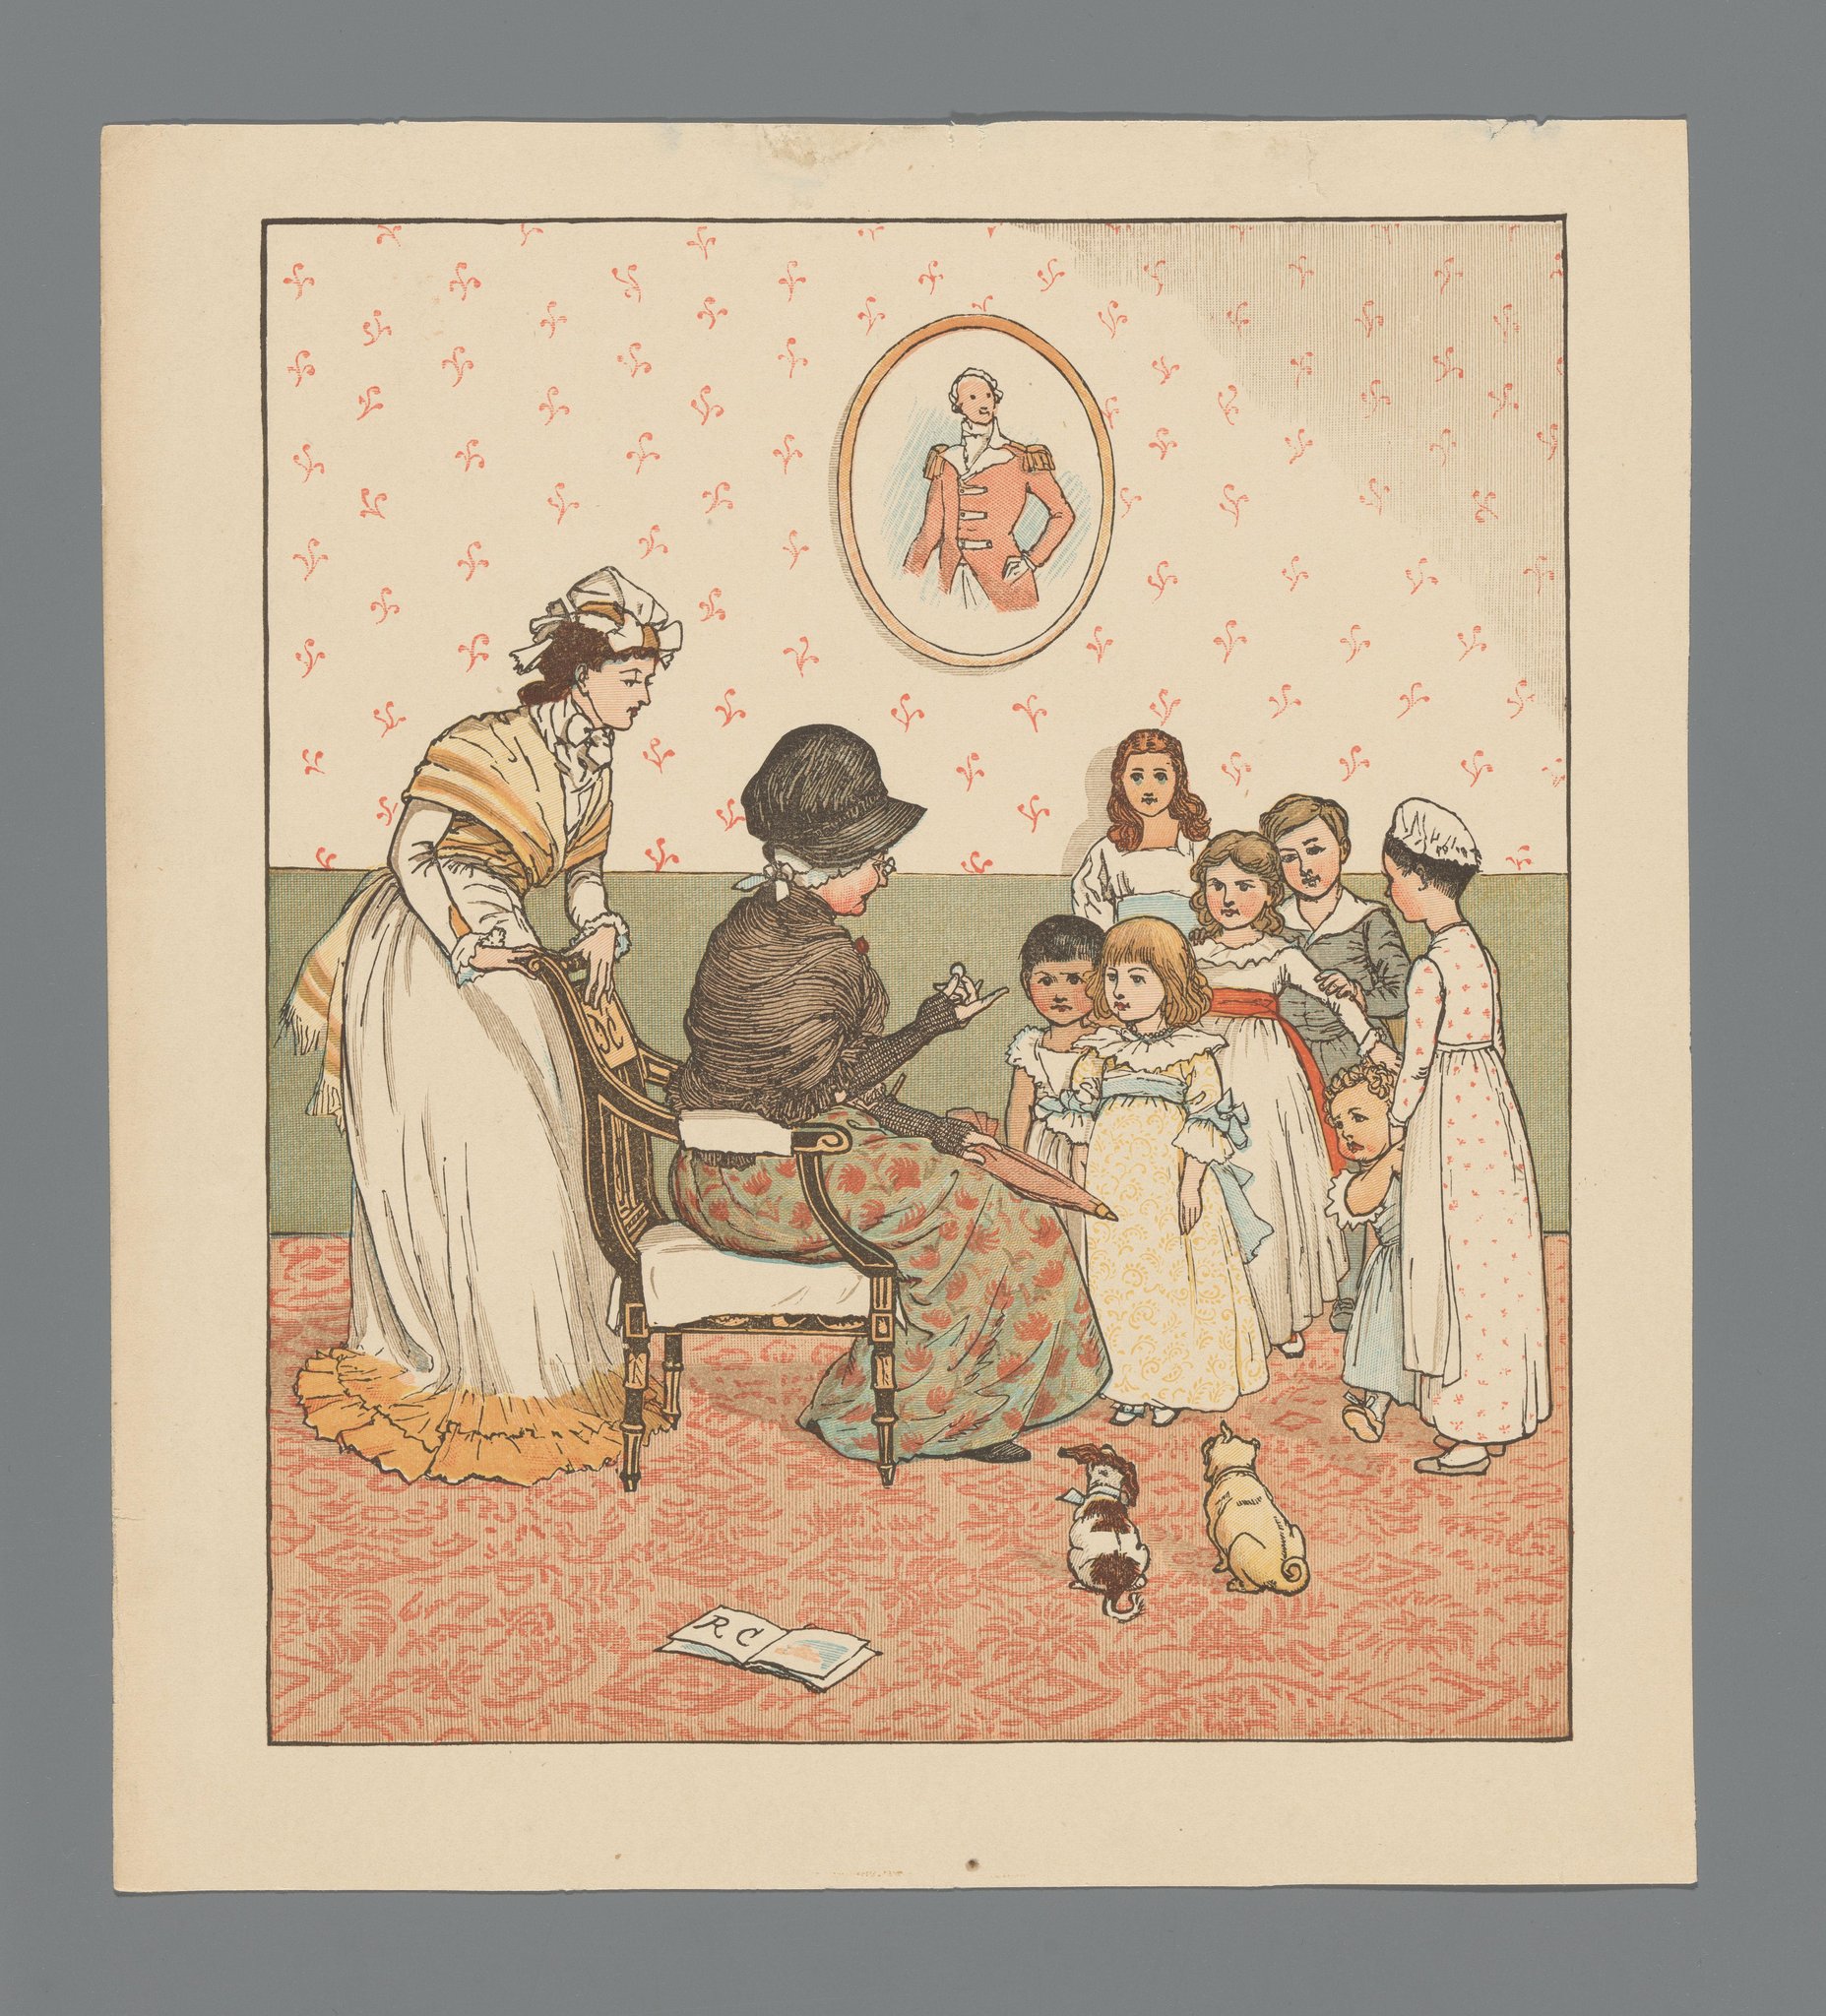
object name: book illustration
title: Sing a song for sixpence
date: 1880-1927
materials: paper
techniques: wood engraving, letterpress printing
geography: london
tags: rickshaw (+ three persons ~ traffic and transport), family life at home, children singing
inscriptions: collector's mark: Lugt 2166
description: Prent uit: Sing a song of sixpence. Londen: George Routledge & Sons, 1880. Of uit een later gepubliceerde (gebundelde) uitgave.